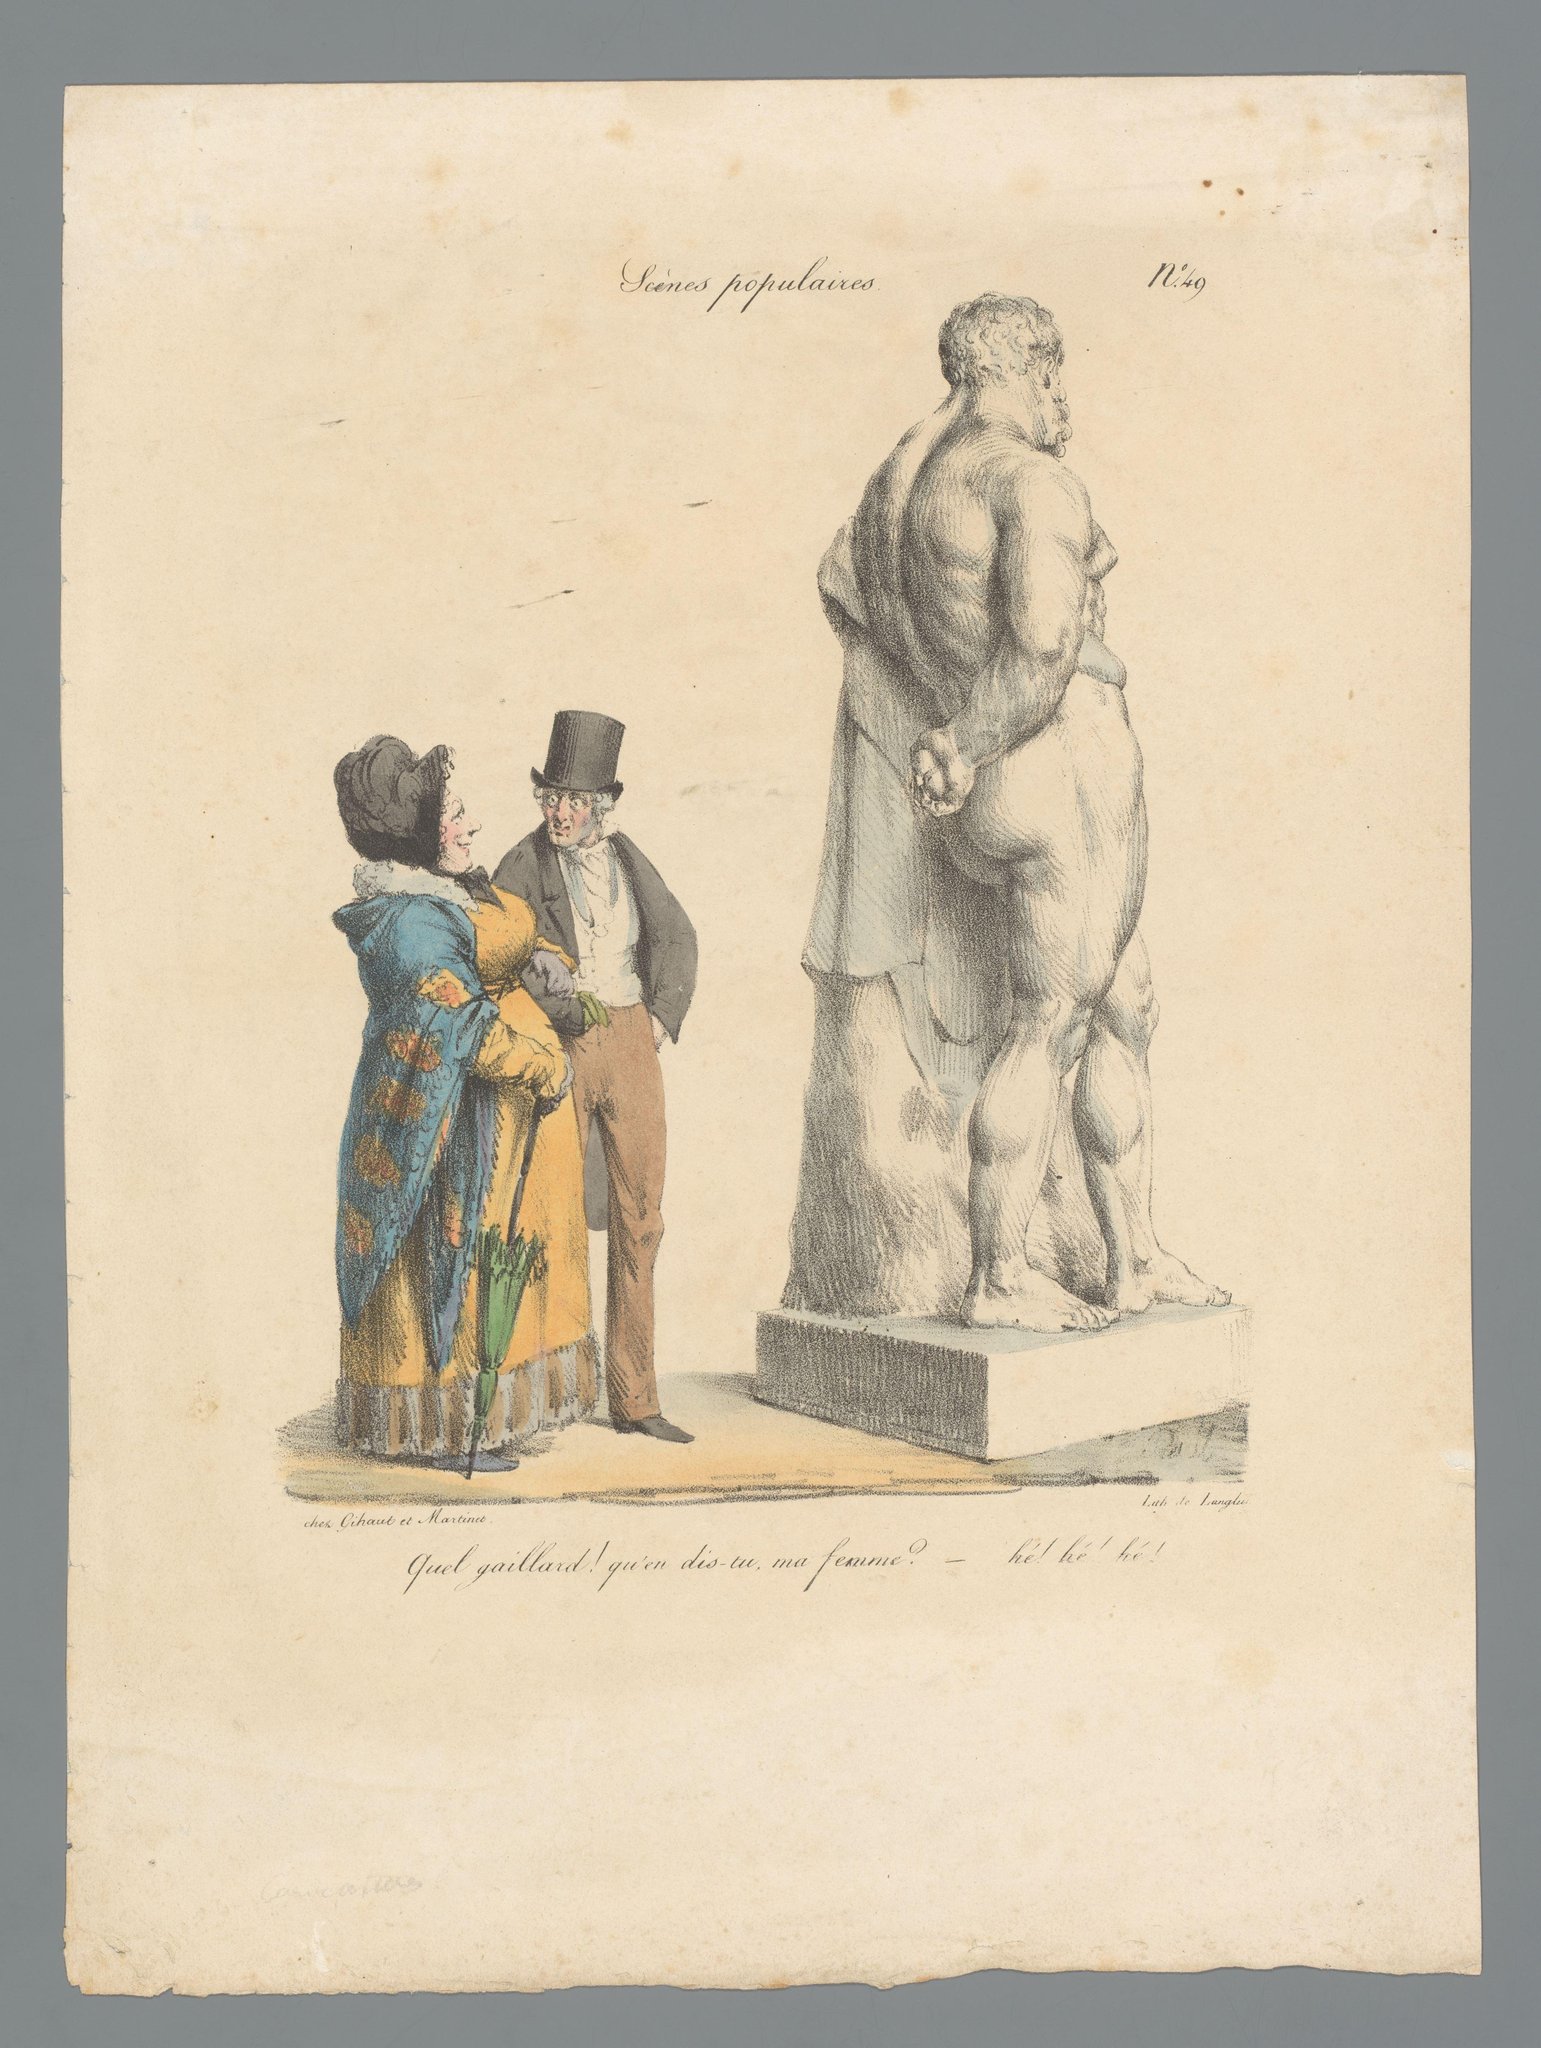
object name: print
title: Man en vrouw bekijken kloek standbeeld van naakte man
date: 1824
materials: paper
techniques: hand coloring, lithograph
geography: paris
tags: adult woman, adult man, monument, statue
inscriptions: collector's mark: Lugt 2228, inscription: ‘J. Ducrot, 31 Rue de Tournon/ 28 Dec. 1964. N.F. 6.-’